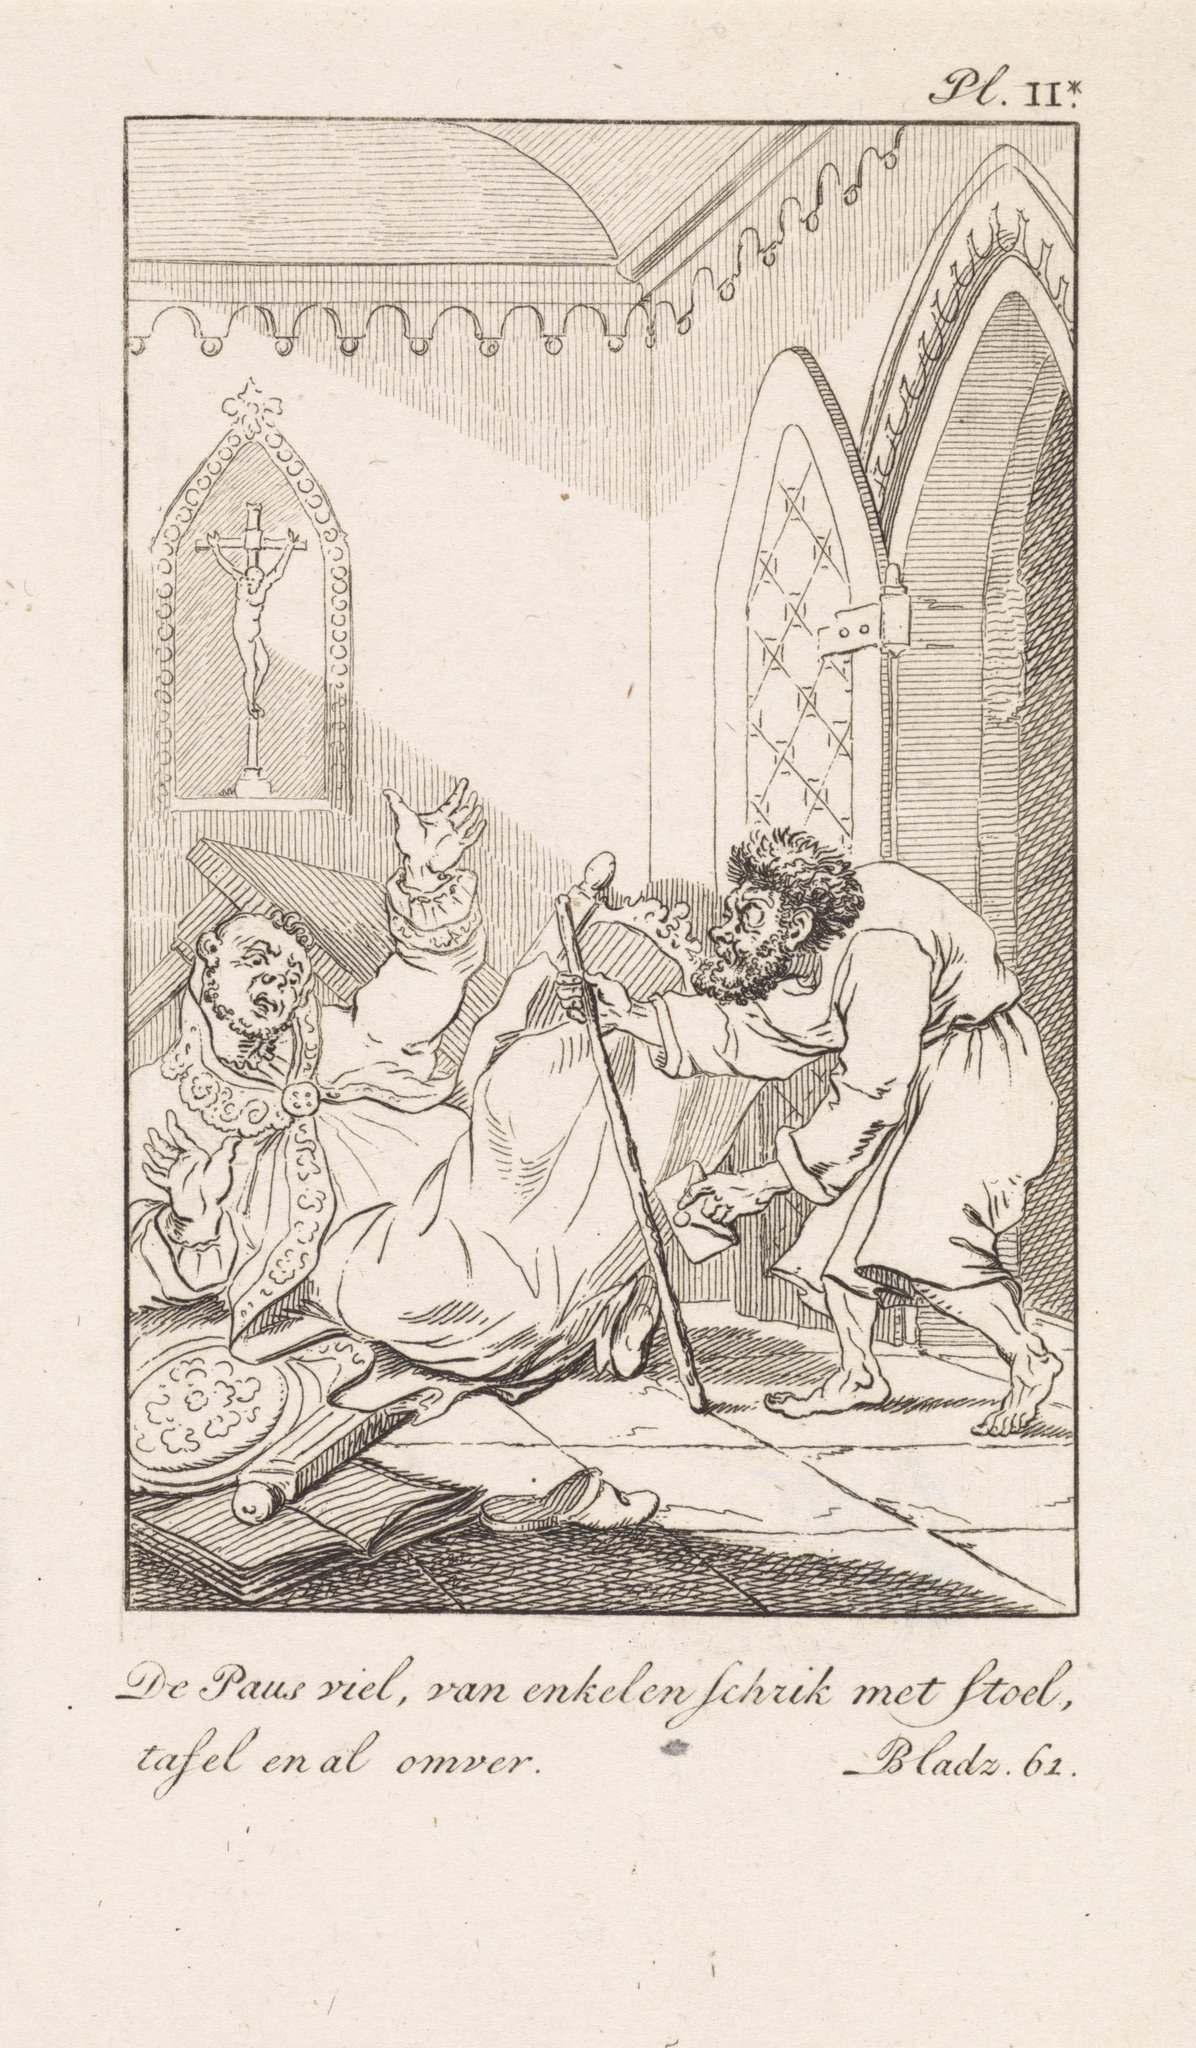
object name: print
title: De Paus viel, van enkelen schrik met stoel, tafel een al omver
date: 1802-1809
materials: paper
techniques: etching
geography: haarlem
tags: hunchback, political caricatures and satires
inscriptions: collector's mark: Lugt 2228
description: Een geestelijke valt met stoel en al om, zijn handen in de lucht. Een man met gebogen rug en een staf en een brief in de hand komt op blote voeten aanlopen. Rechtsboven: Pl. II*. Rechtsonder: Bladz. 61.